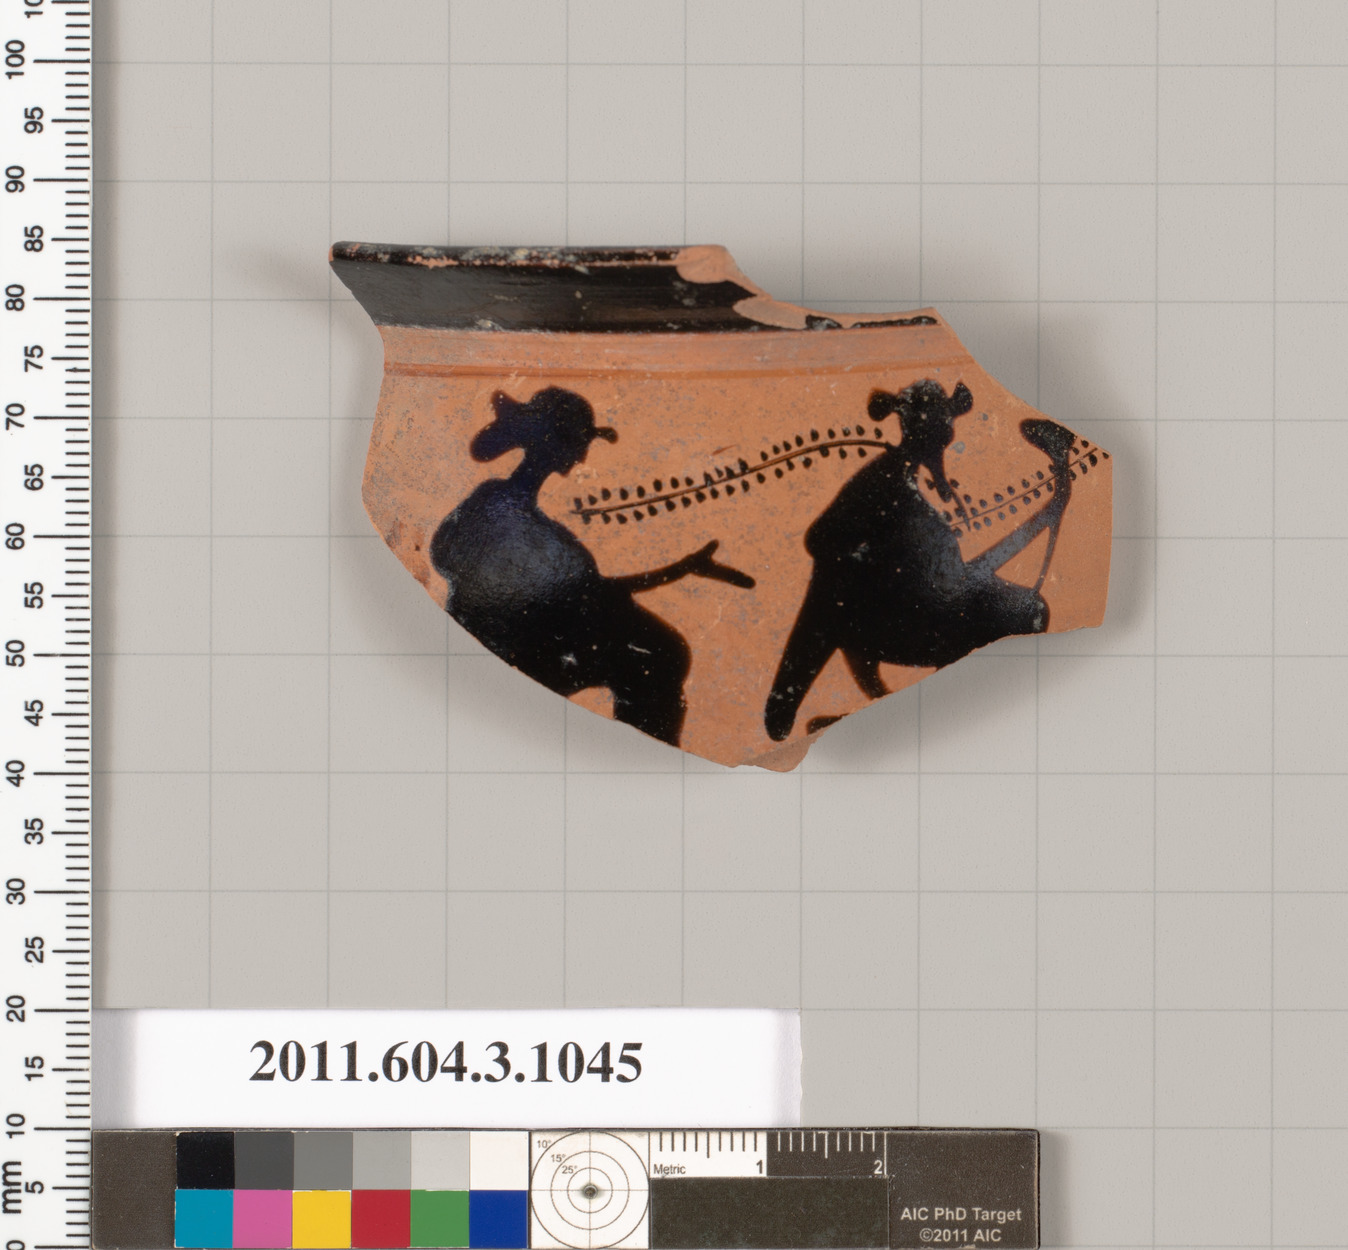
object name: mastoid fragment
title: Terracotta fragment of a mastoid (drinking cup with narrow base)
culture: greek, attic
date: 534-468 BCE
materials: terracotta